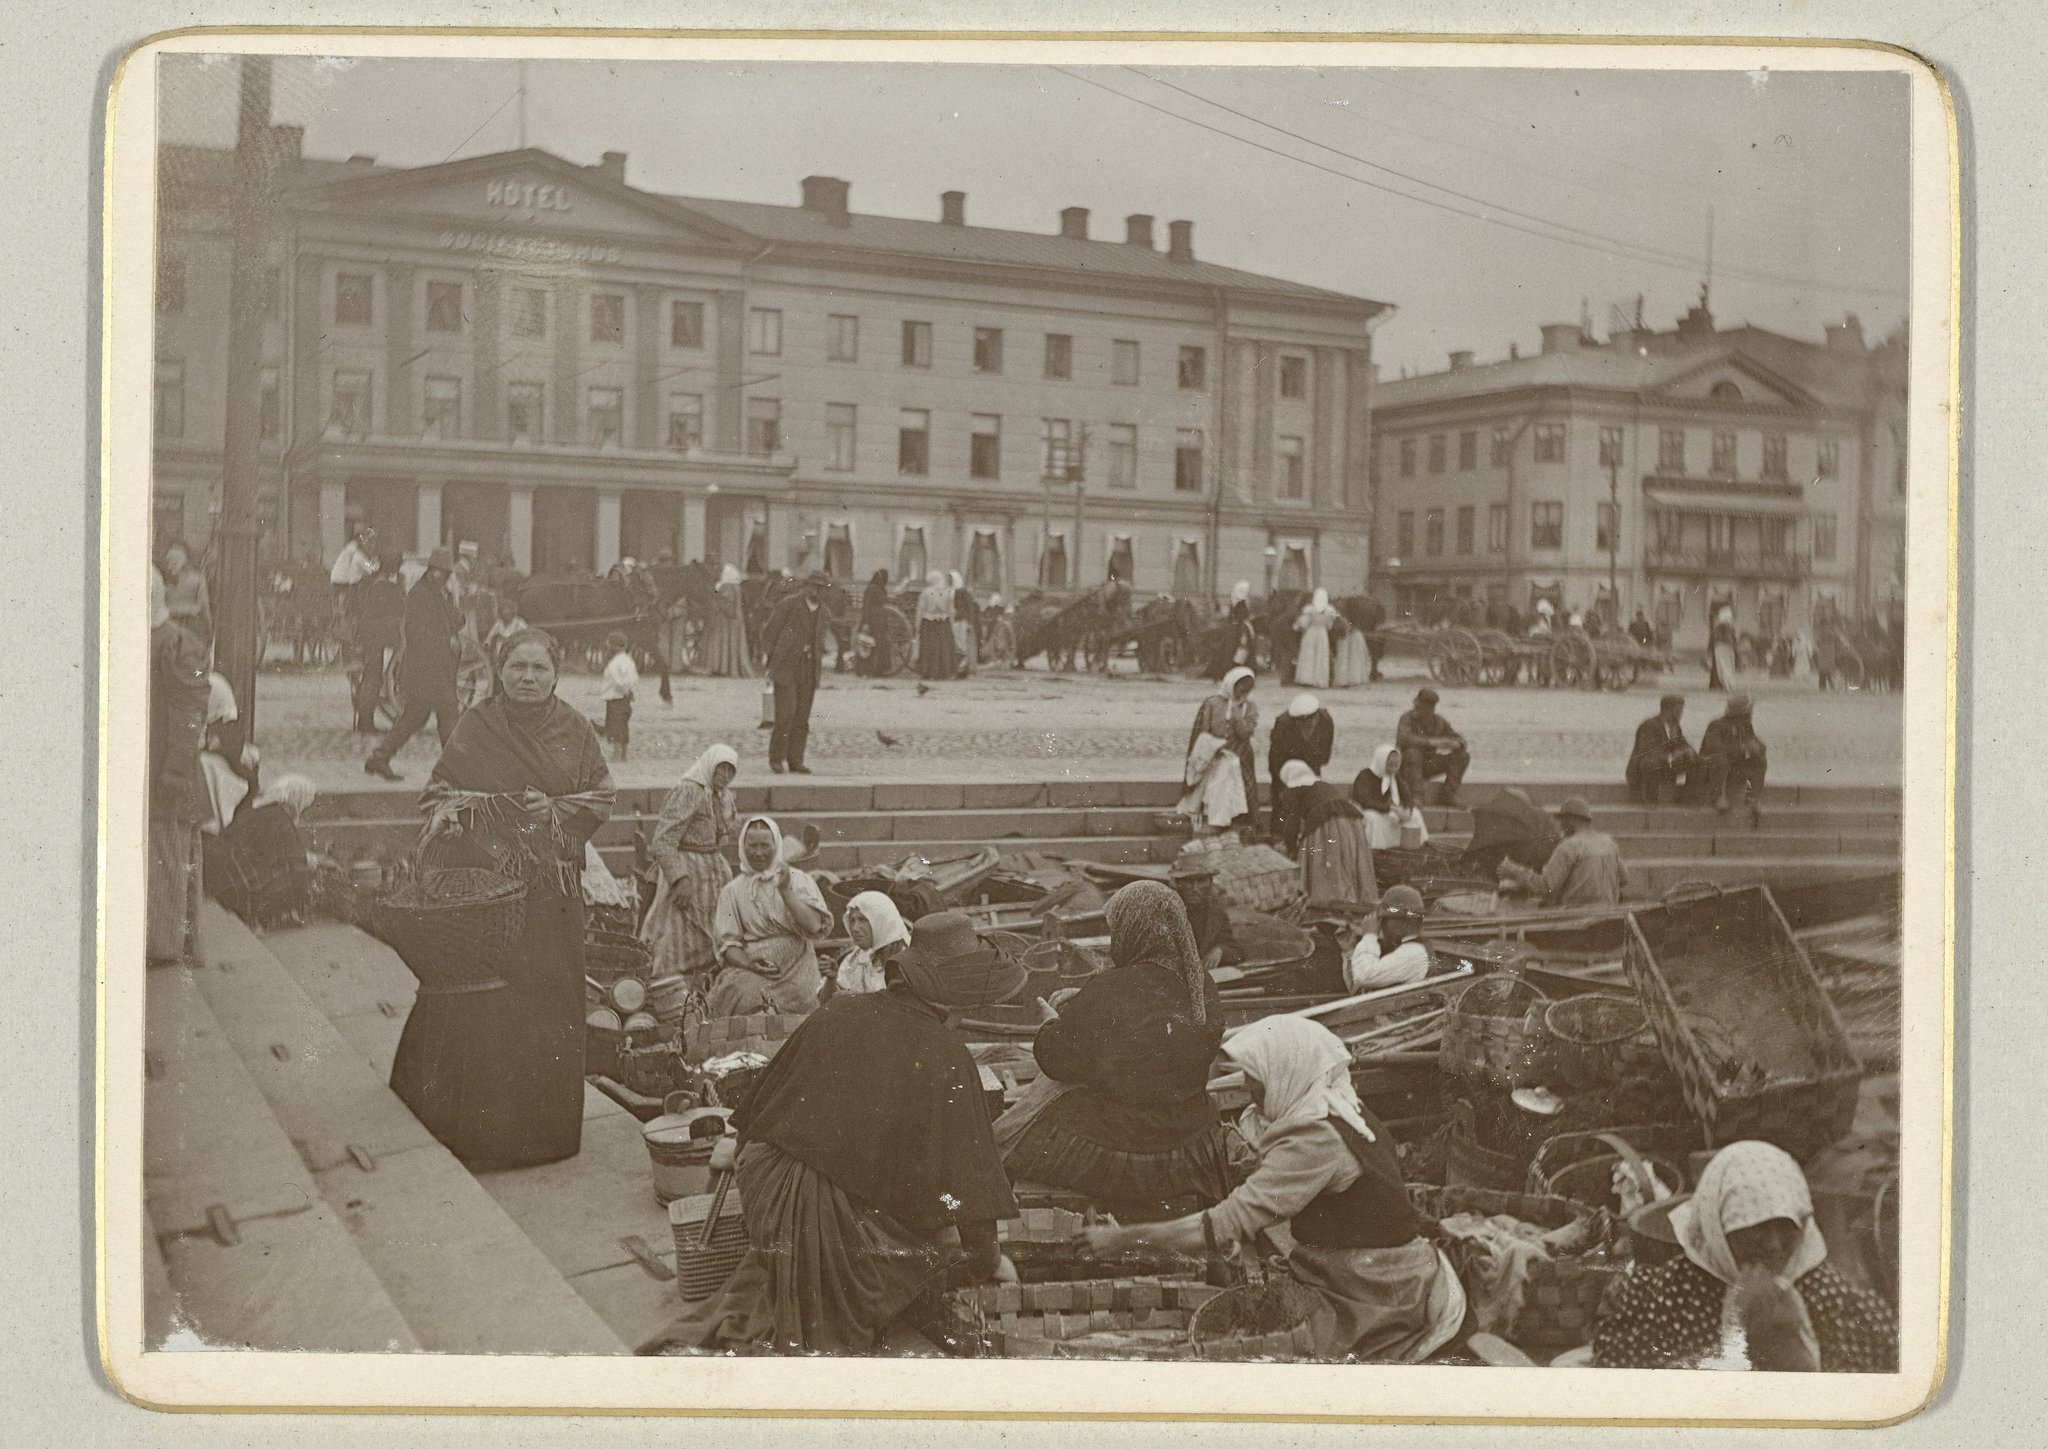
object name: photograph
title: Helsingfors Finland, Vischmarkt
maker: henry pauw van wieldrecht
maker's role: fotograaf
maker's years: 1863-1912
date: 1898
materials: paper, photographic support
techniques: albumen print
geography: netherlands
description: De markt Vene Satama in Helsinki met aangemeerde bootjes met handel op de drukbezochte kade.